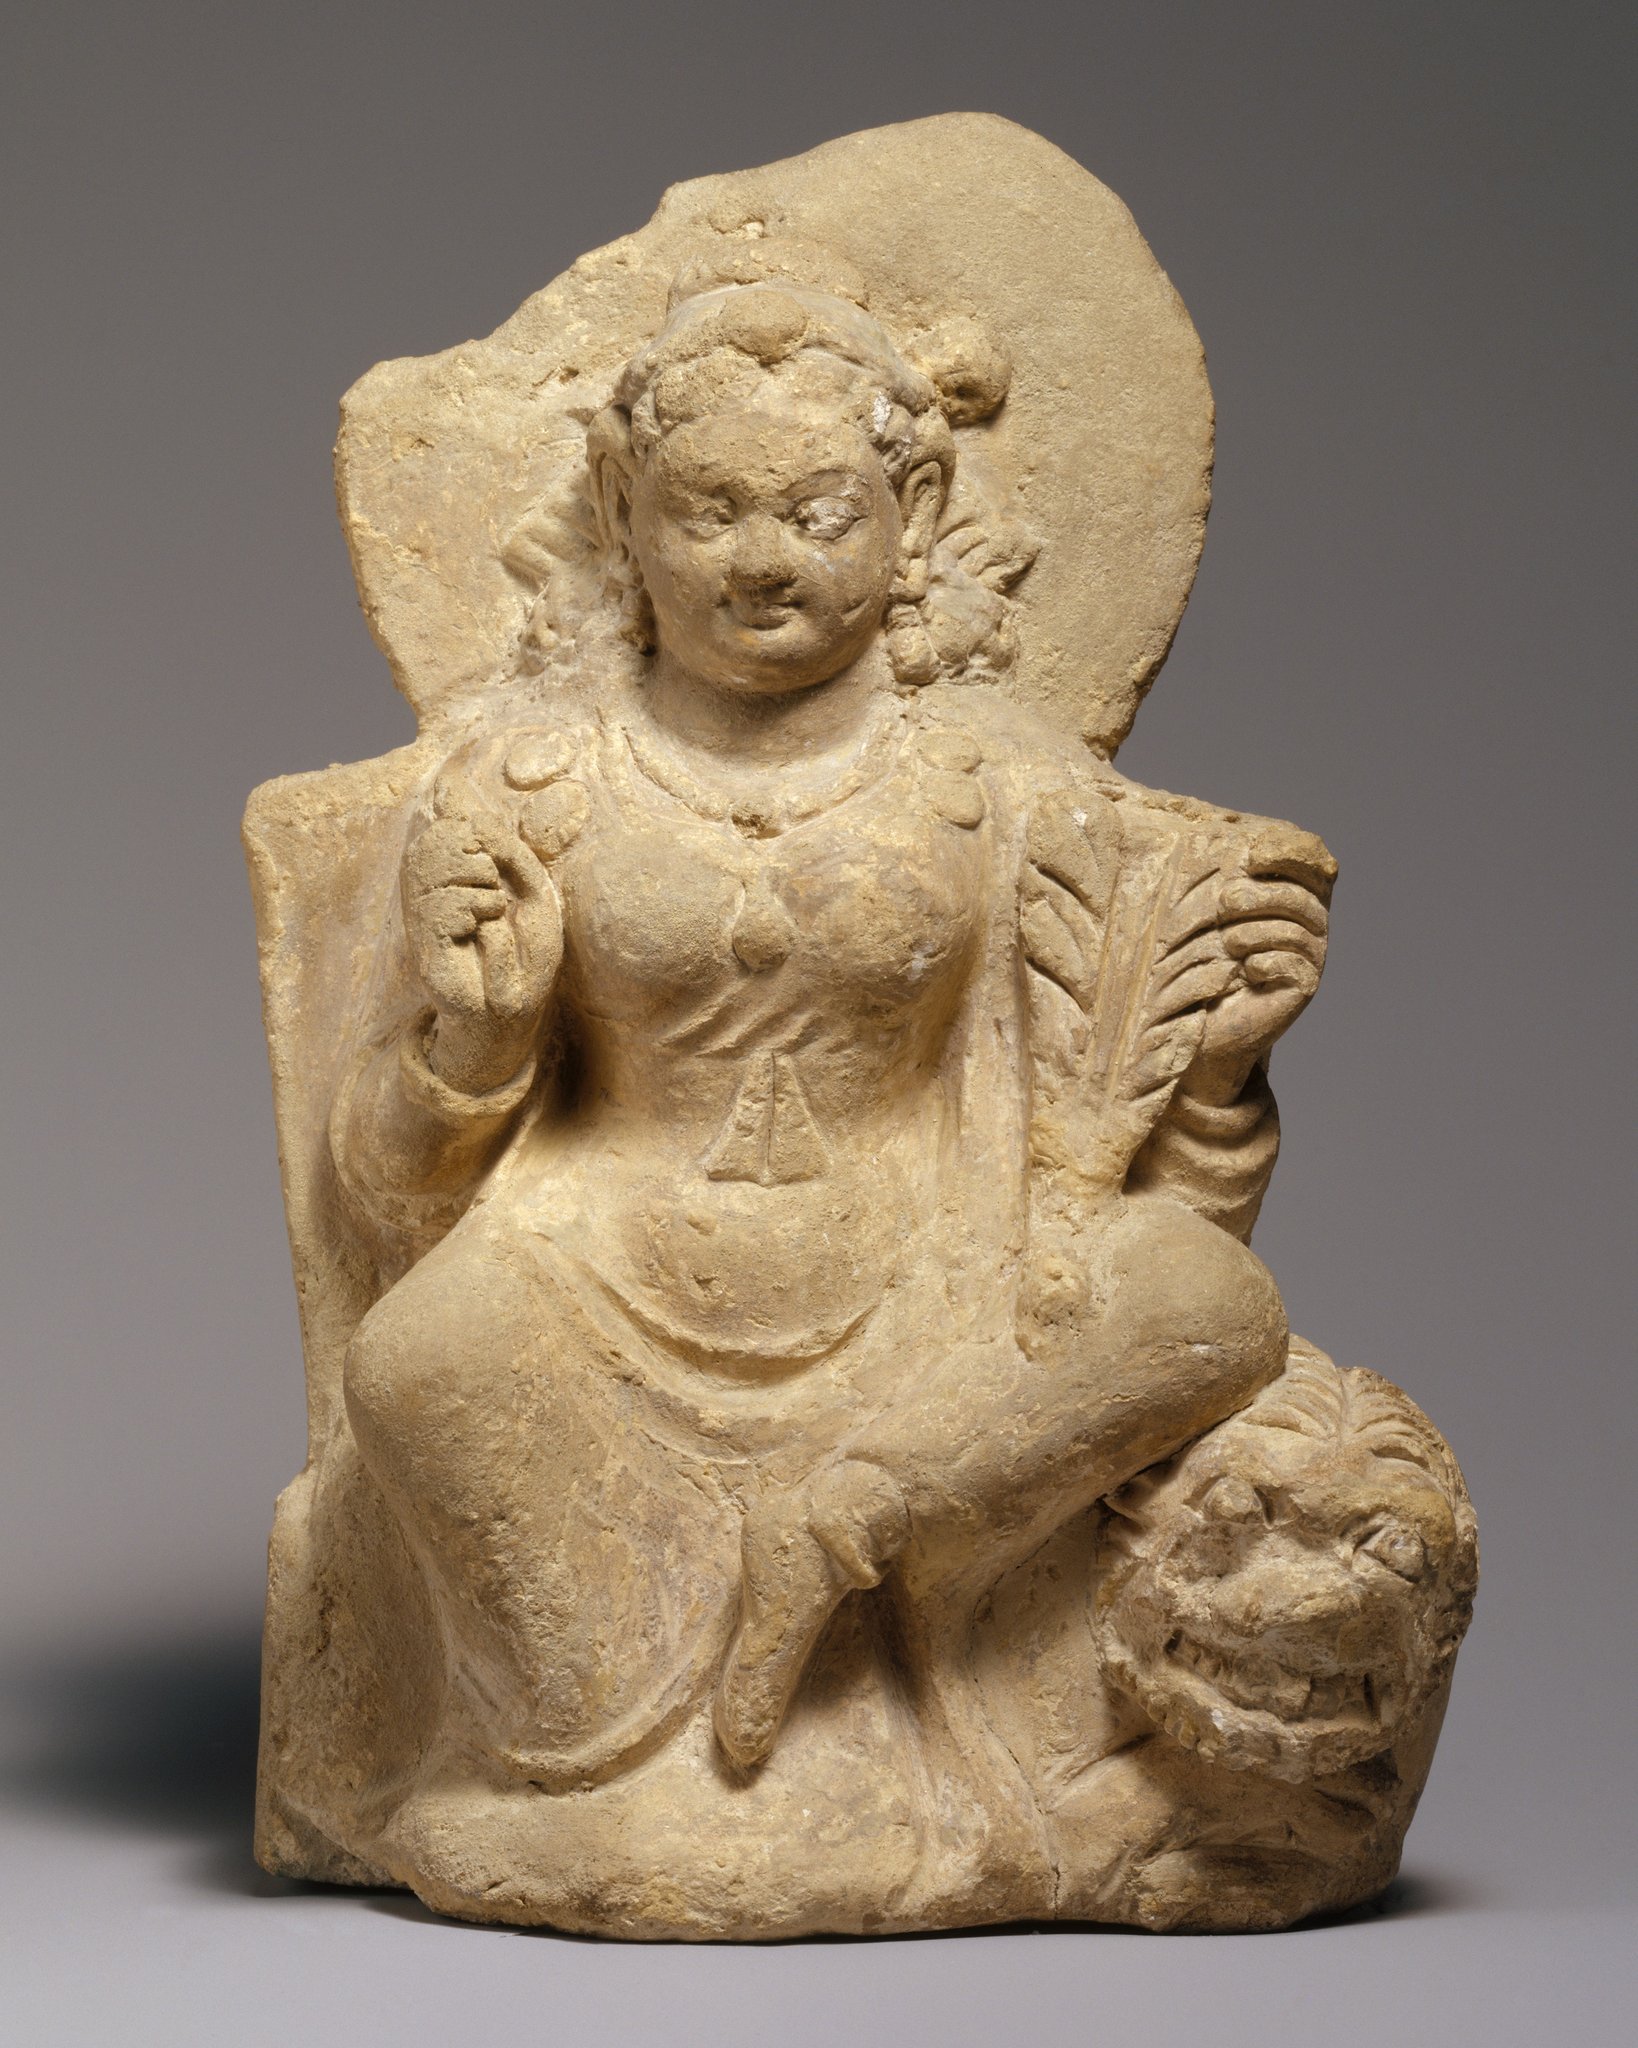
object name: icon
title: Goddess, Possibly Nana, Seated on a Lion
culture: afghan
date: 401-600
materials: plaster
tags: gandharan,lions